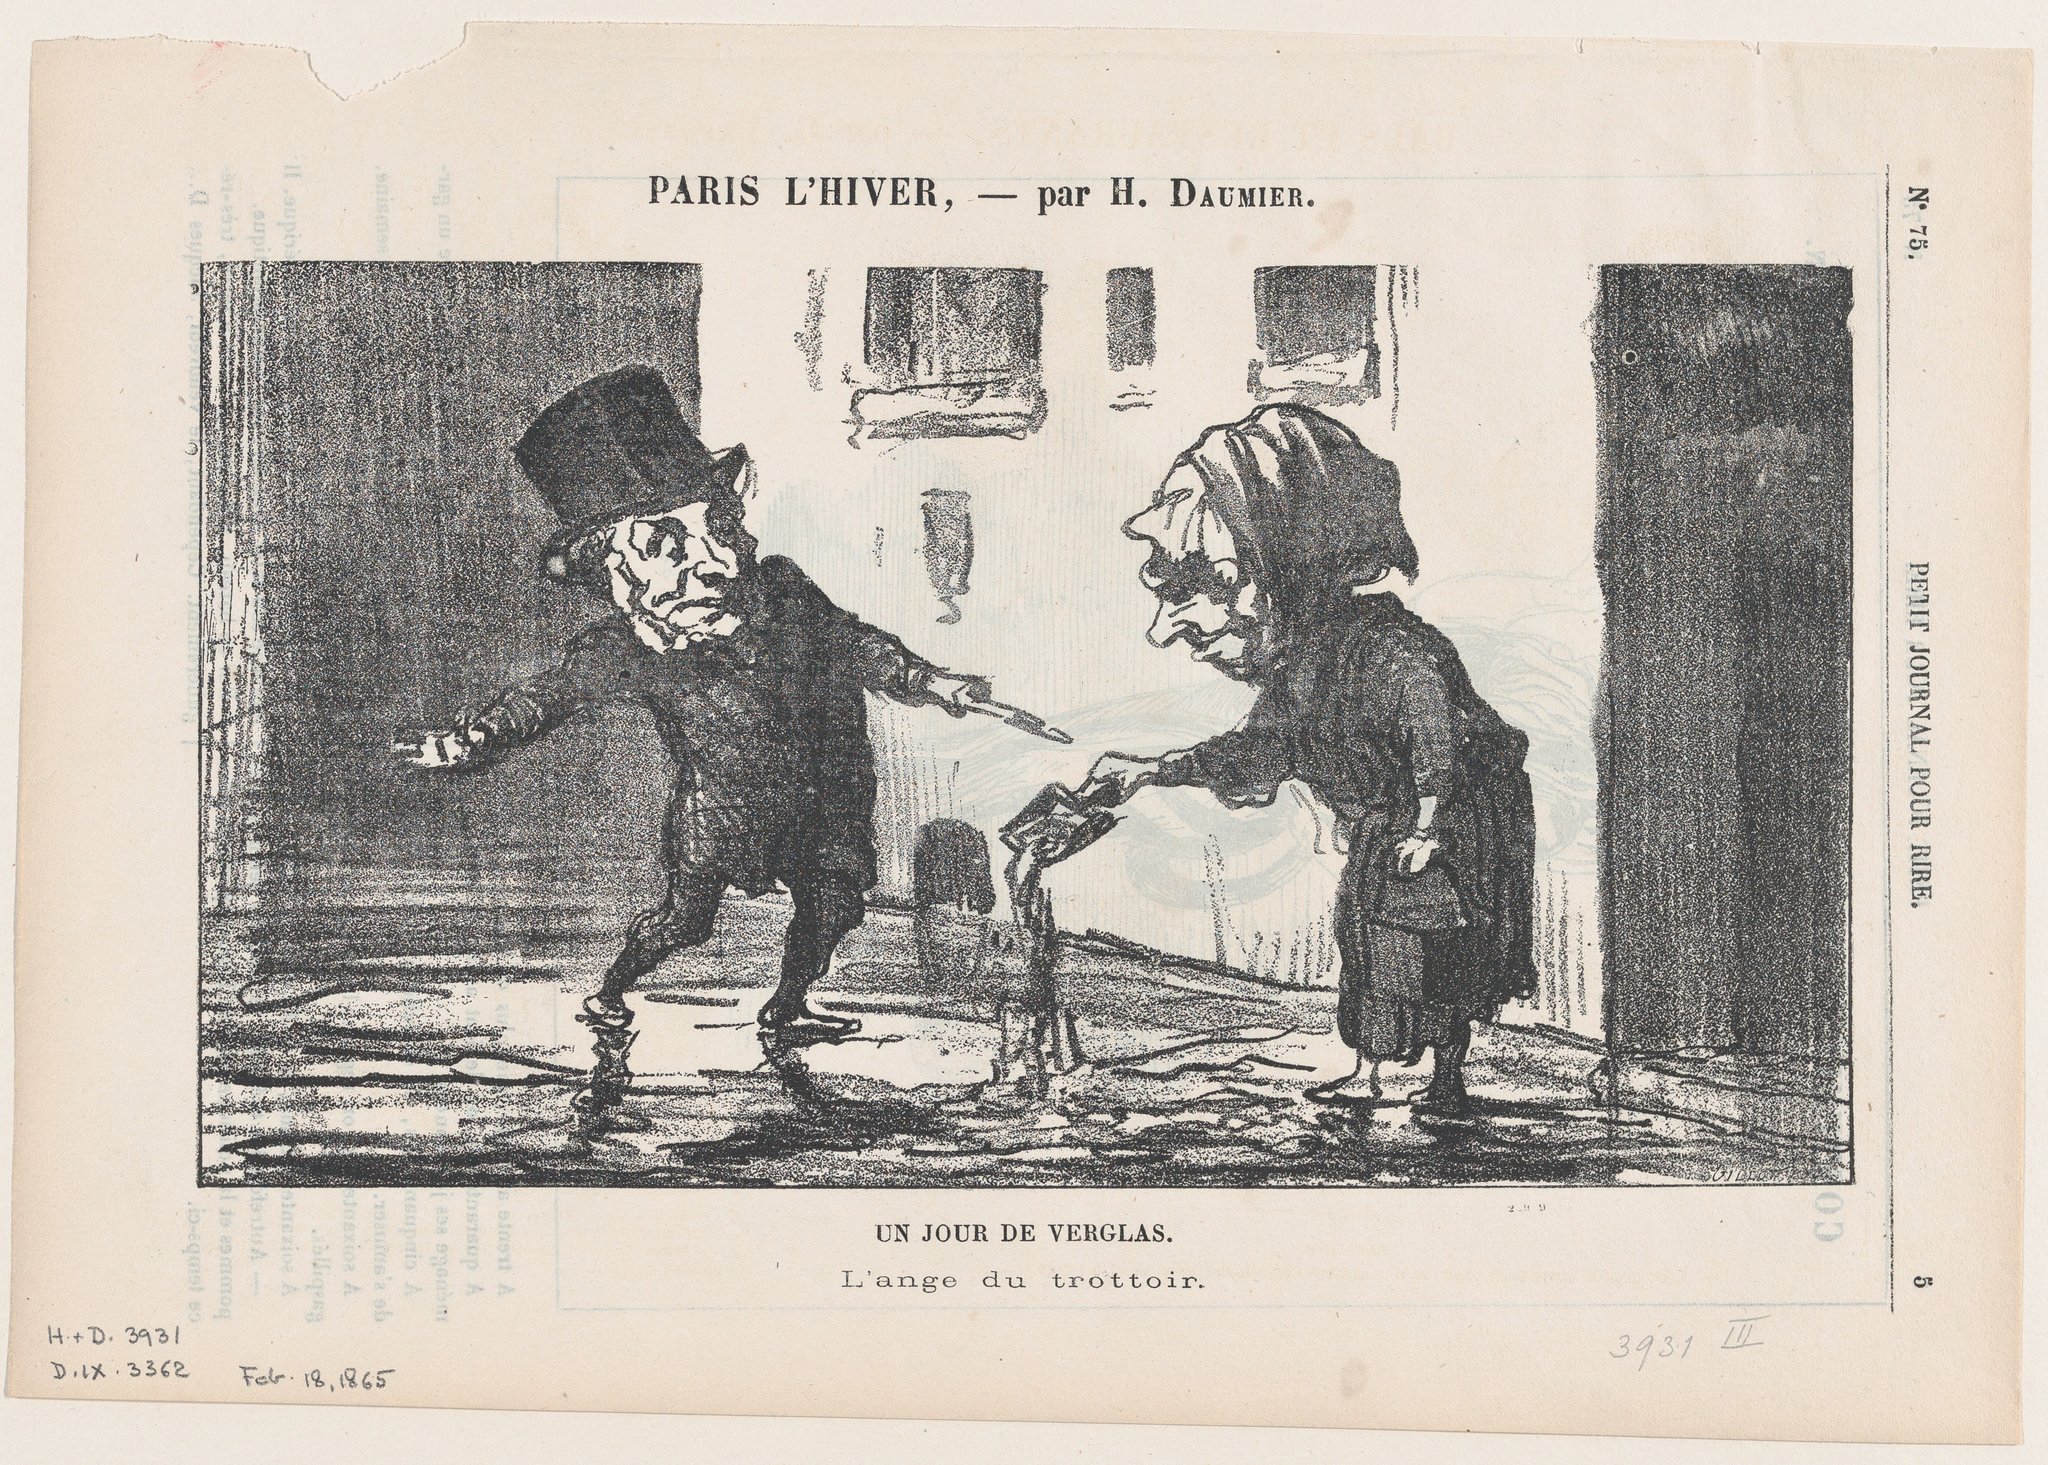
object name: print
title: A day of black ice, the angel of the sidewalk, from "Paris in Winter"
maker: honoré daumier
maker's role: artist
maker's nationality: french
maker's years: 1808-1879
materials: paper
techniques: lithograph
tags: men,women